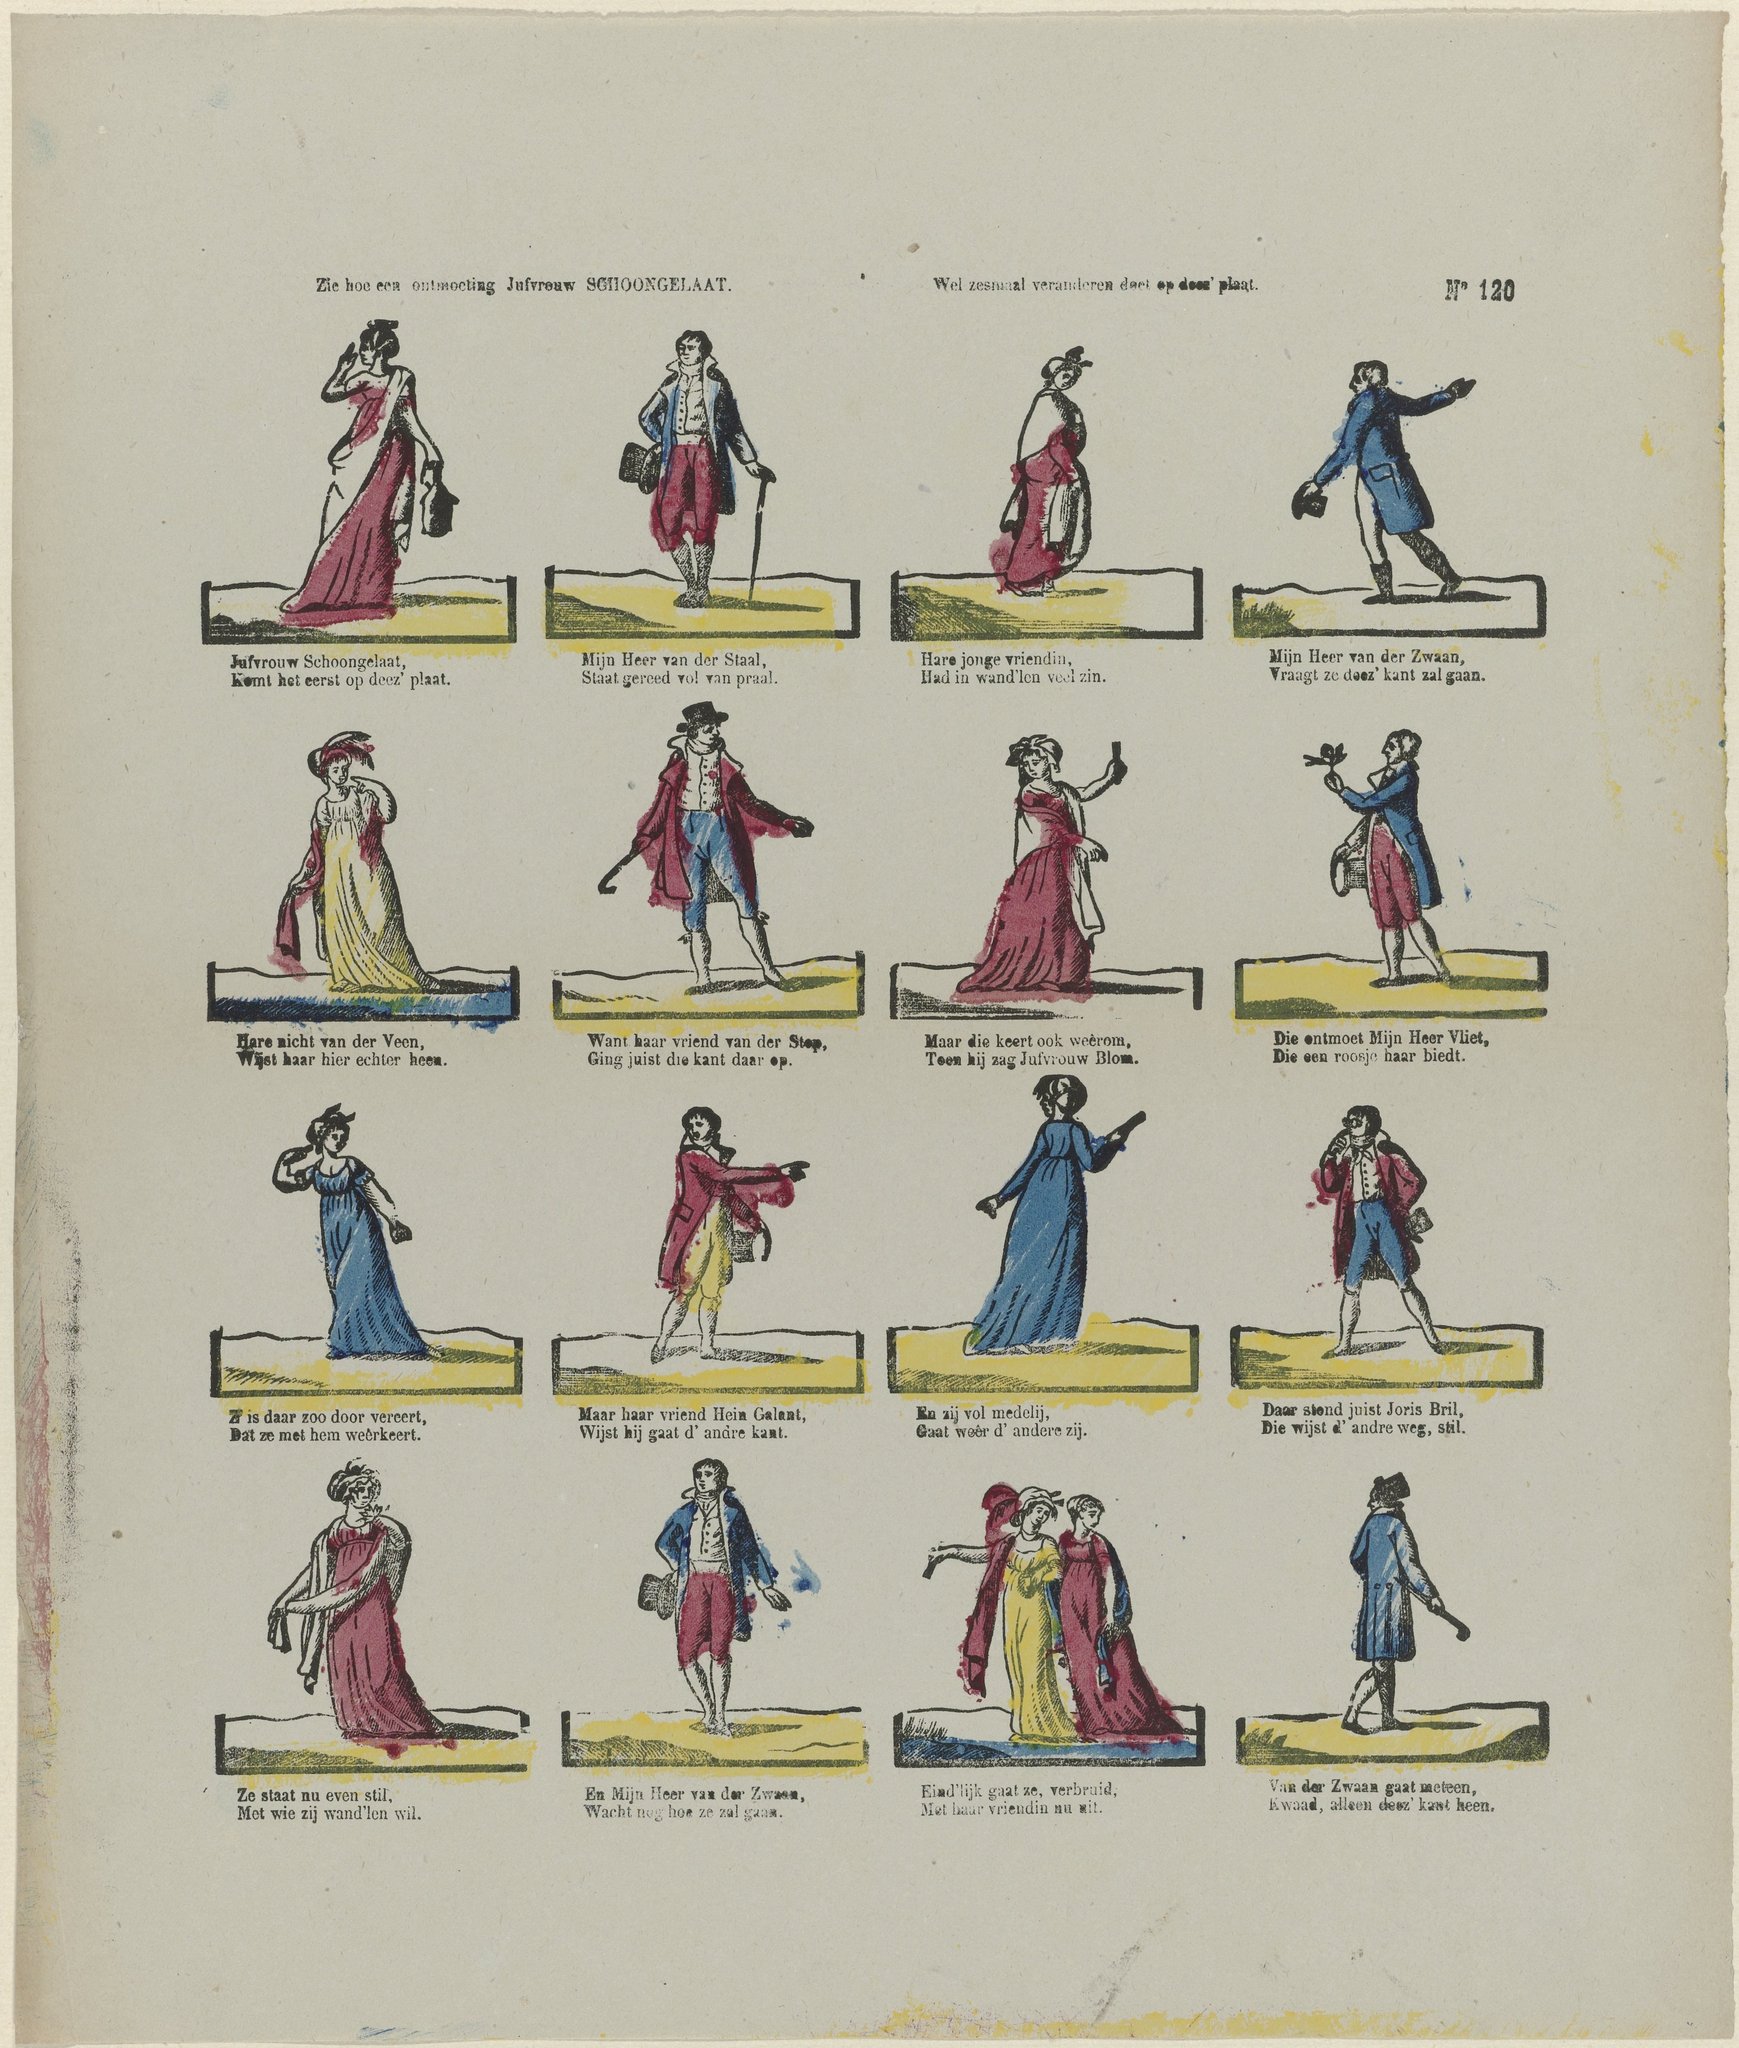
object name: popular print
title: Zie hoe een ontmoeting jufvrouw schoongelaat / Wel zesmaal veranderen doet op deez' plaat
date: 1827-1894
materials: paper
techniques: colour, letterpress printing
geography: schaarbeek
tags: characters (human types)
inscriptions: collector's mark: Lugt 2760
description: Blad met 16 voorstellingen van verschillende figuren. Onder elke afbeelding een tweeregelig vers. Genummerd rechtsboven: No 120.